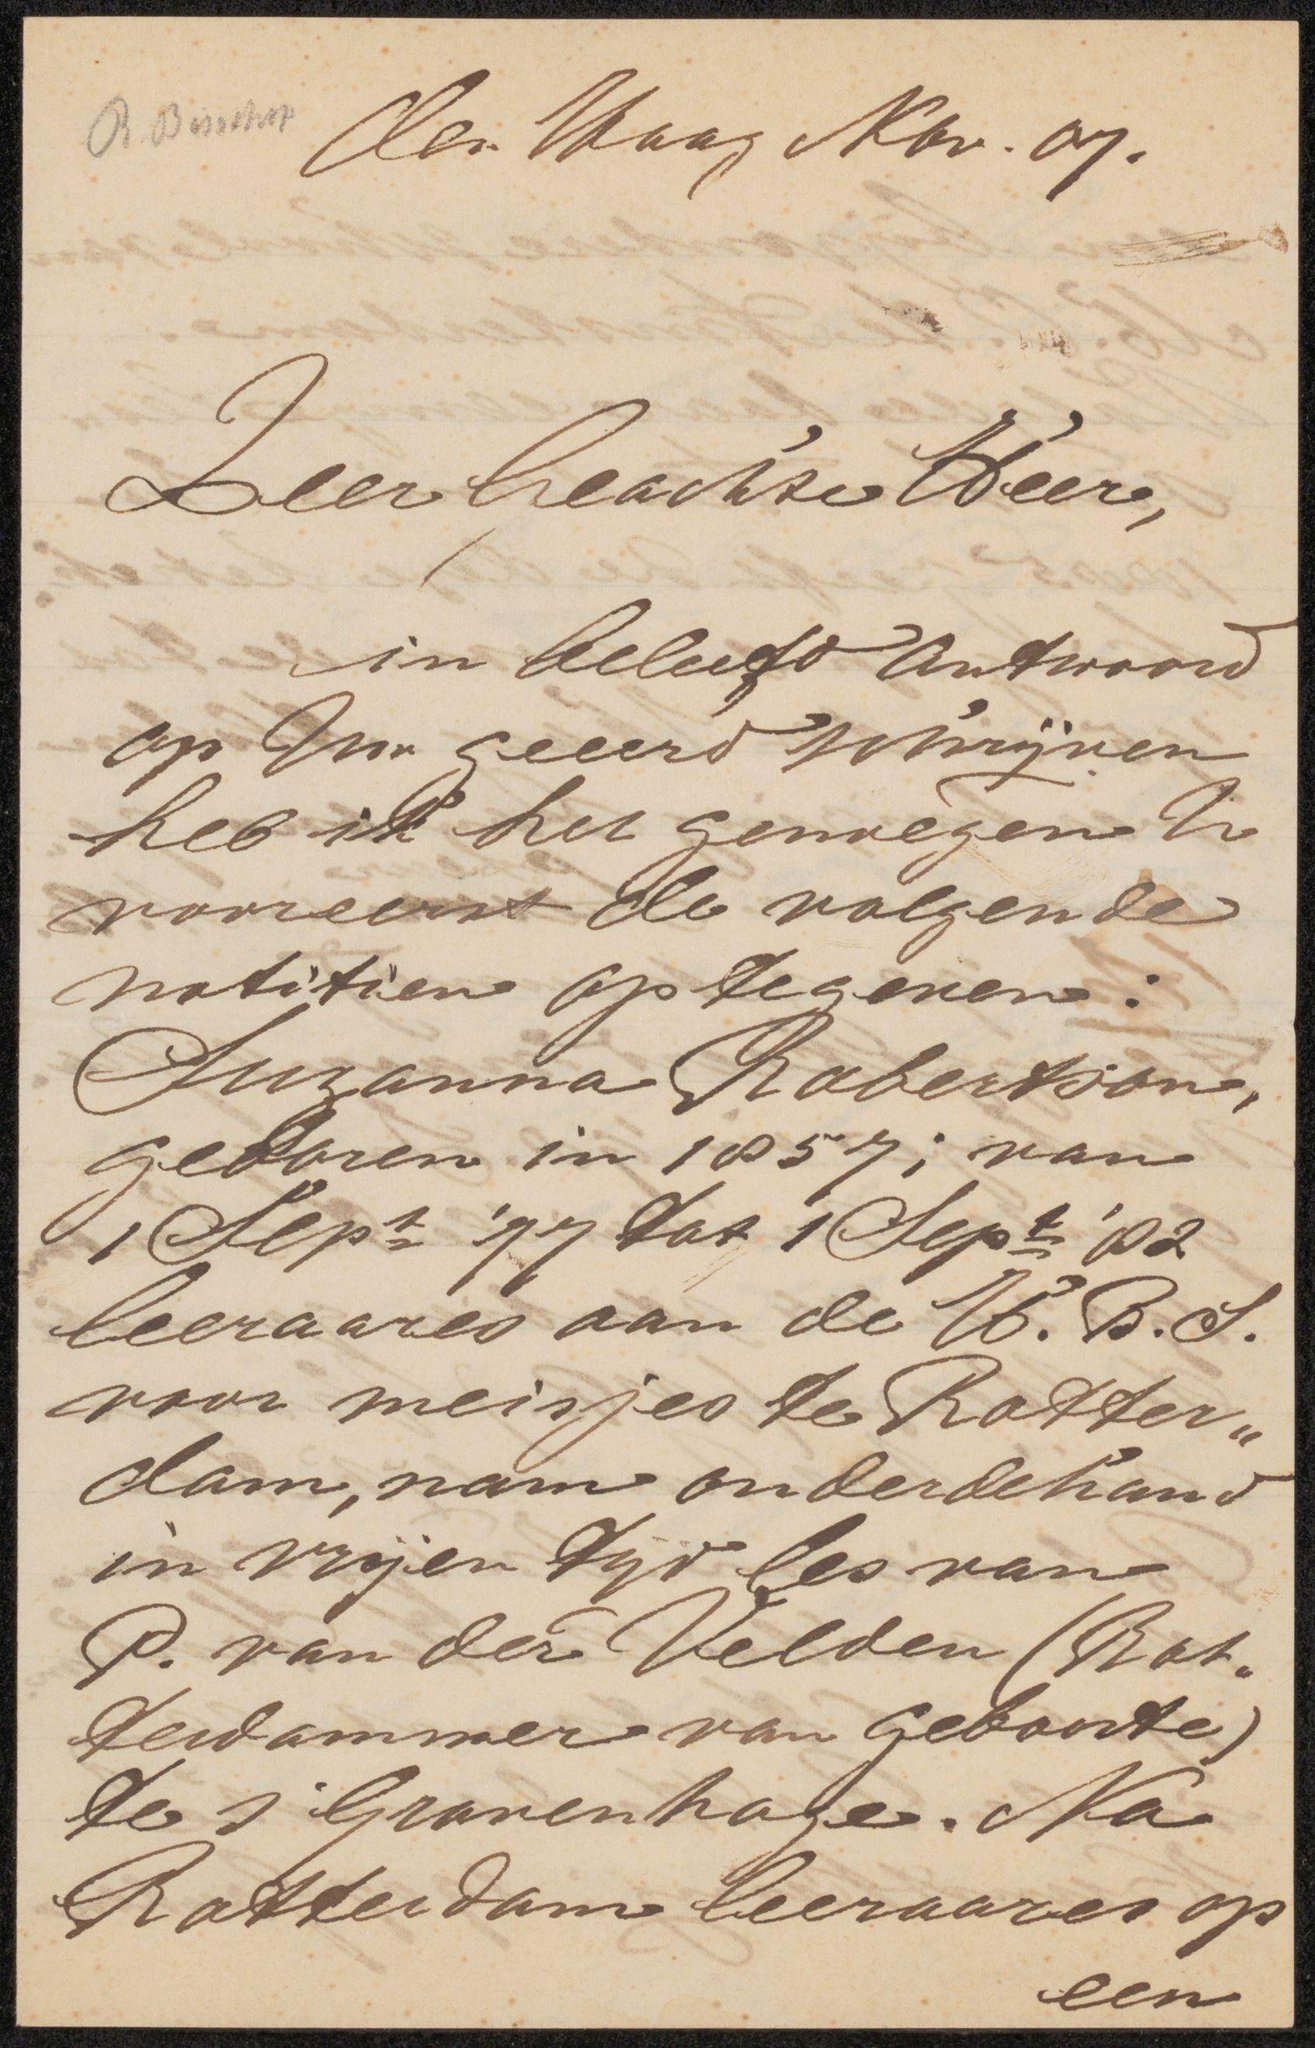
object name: letter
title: Brief aan Pieter Haverkorn van Rijsewijk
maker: richard bisschop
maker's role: draughtsman, painter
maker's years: 1849-1926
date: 1907-1911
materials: ink, paper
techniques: pen, writing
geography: the hague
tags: petrus van der velden, suze robertson, pieter haverkorn van rijsewijk, distribution of awards ~ art contest, education, tuition of the artist (in general), painting (including book-illumination, miniature-painting), exhibition ~ art, the hague, rotterdam, amsterdam